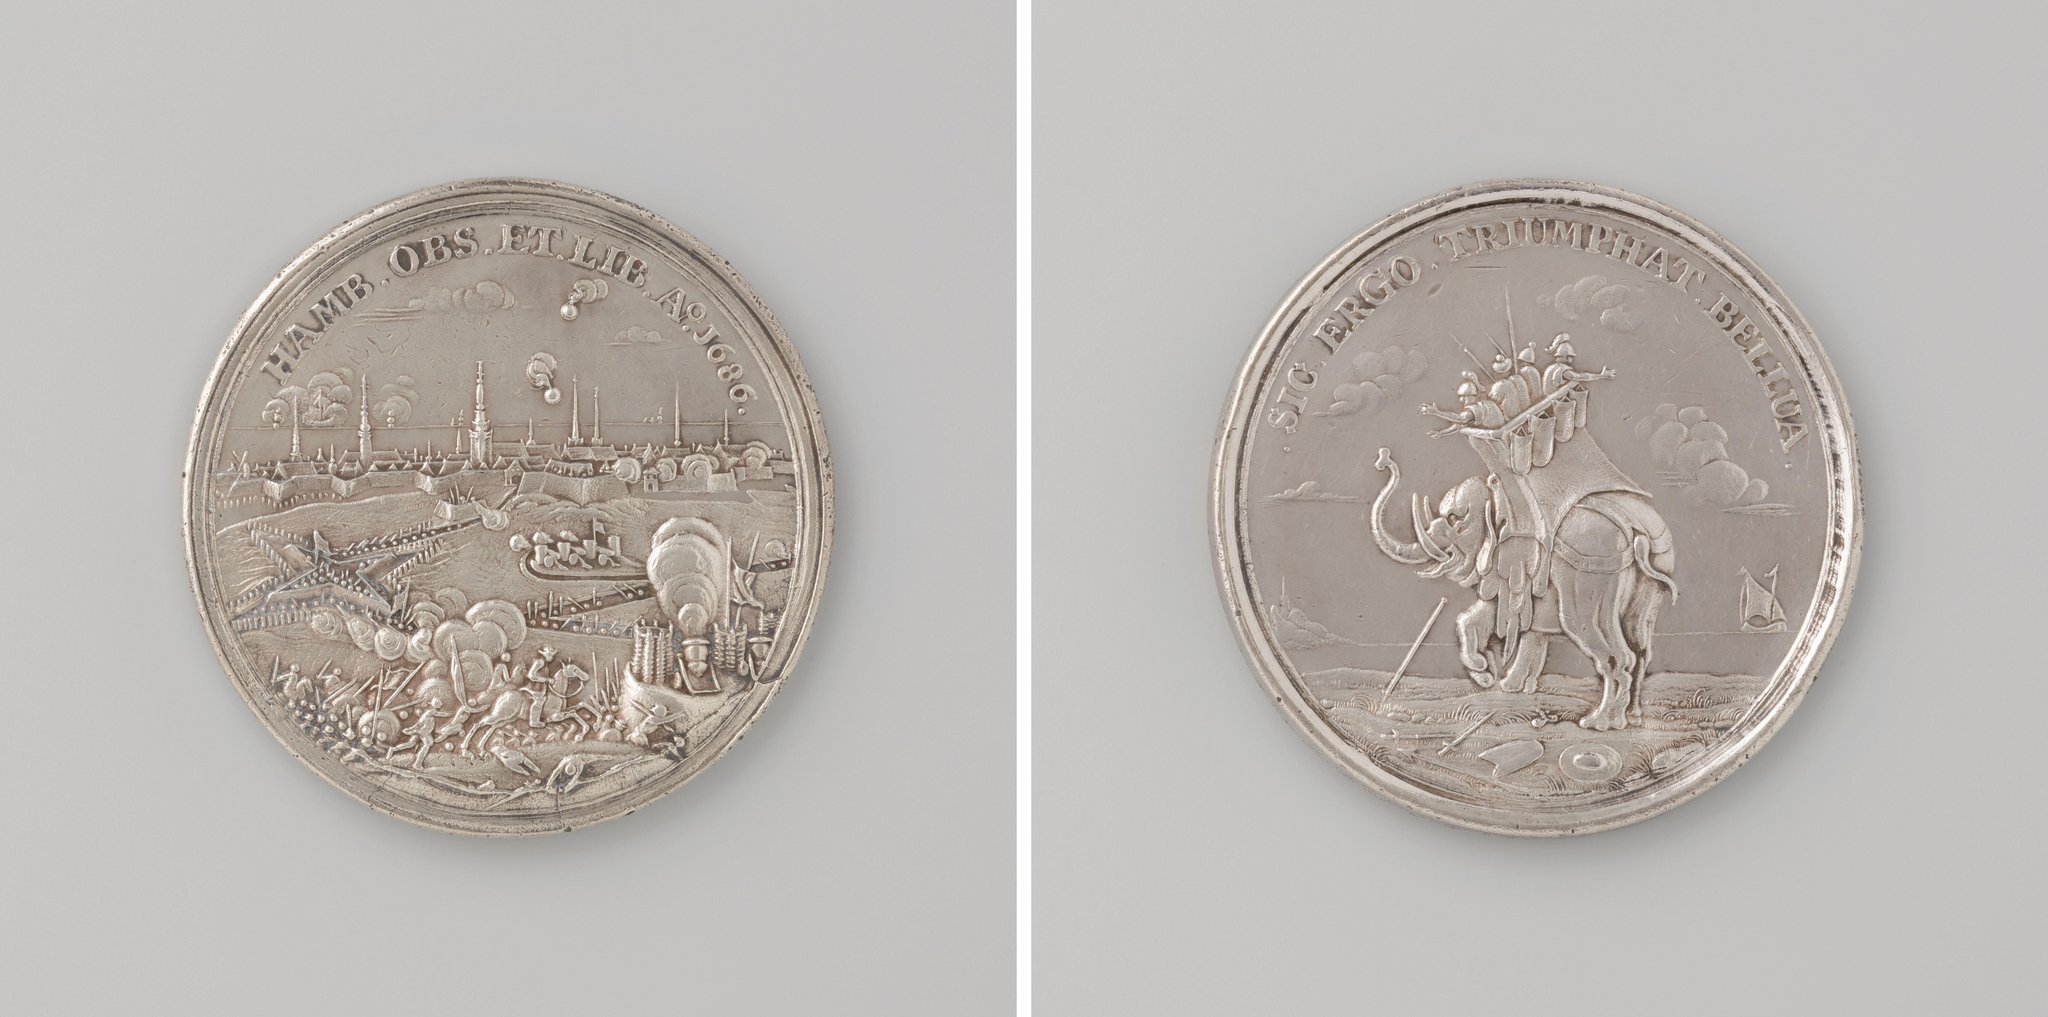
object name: history medal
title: Mislukte belegering van Hamburg door de koning van Denemarken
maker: Anonymous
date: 1686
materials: silver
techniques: striking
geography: germany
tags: copenhagen (city)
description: Zilveren penning. Voorzijde: gezicht op belegerde stad Hamburg binnen omschrift. Keerzijde: olifant met bemande krijgstoren binnen omschrift